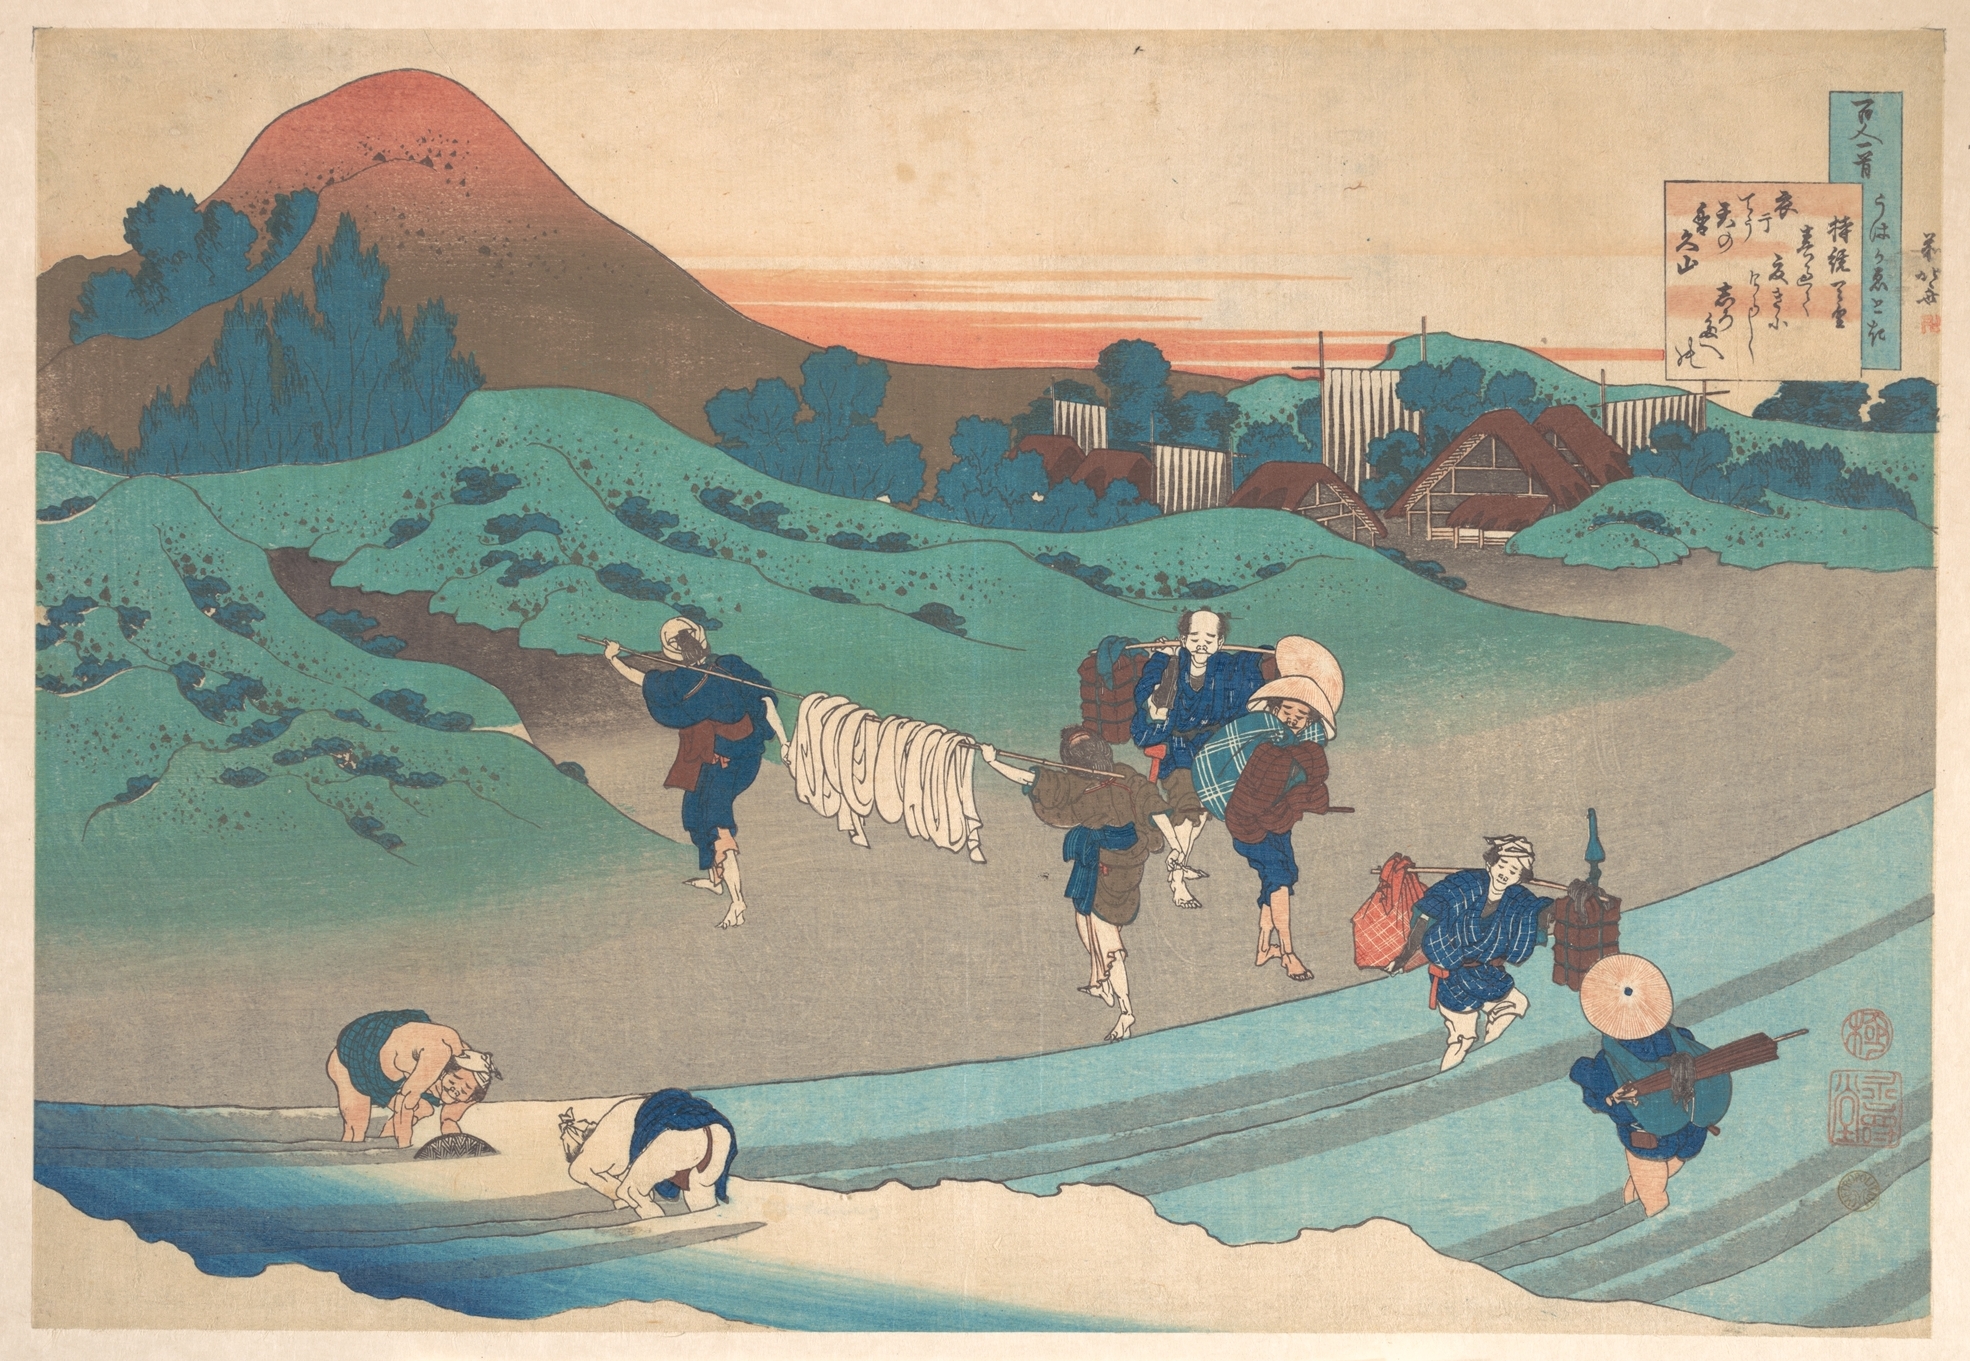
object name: woodblock print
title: Poem by Jitō Tenno (Empress Jitō), from the series One Hundred Poems Explained by the Nurse (Hyakunin isshu uba ga etoki)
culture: japanese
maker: katsushika hokusai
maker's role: artist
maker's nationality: japanese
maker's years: 1760-1849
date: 1839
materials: ink, paper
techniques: woodblock print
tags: men,rivers